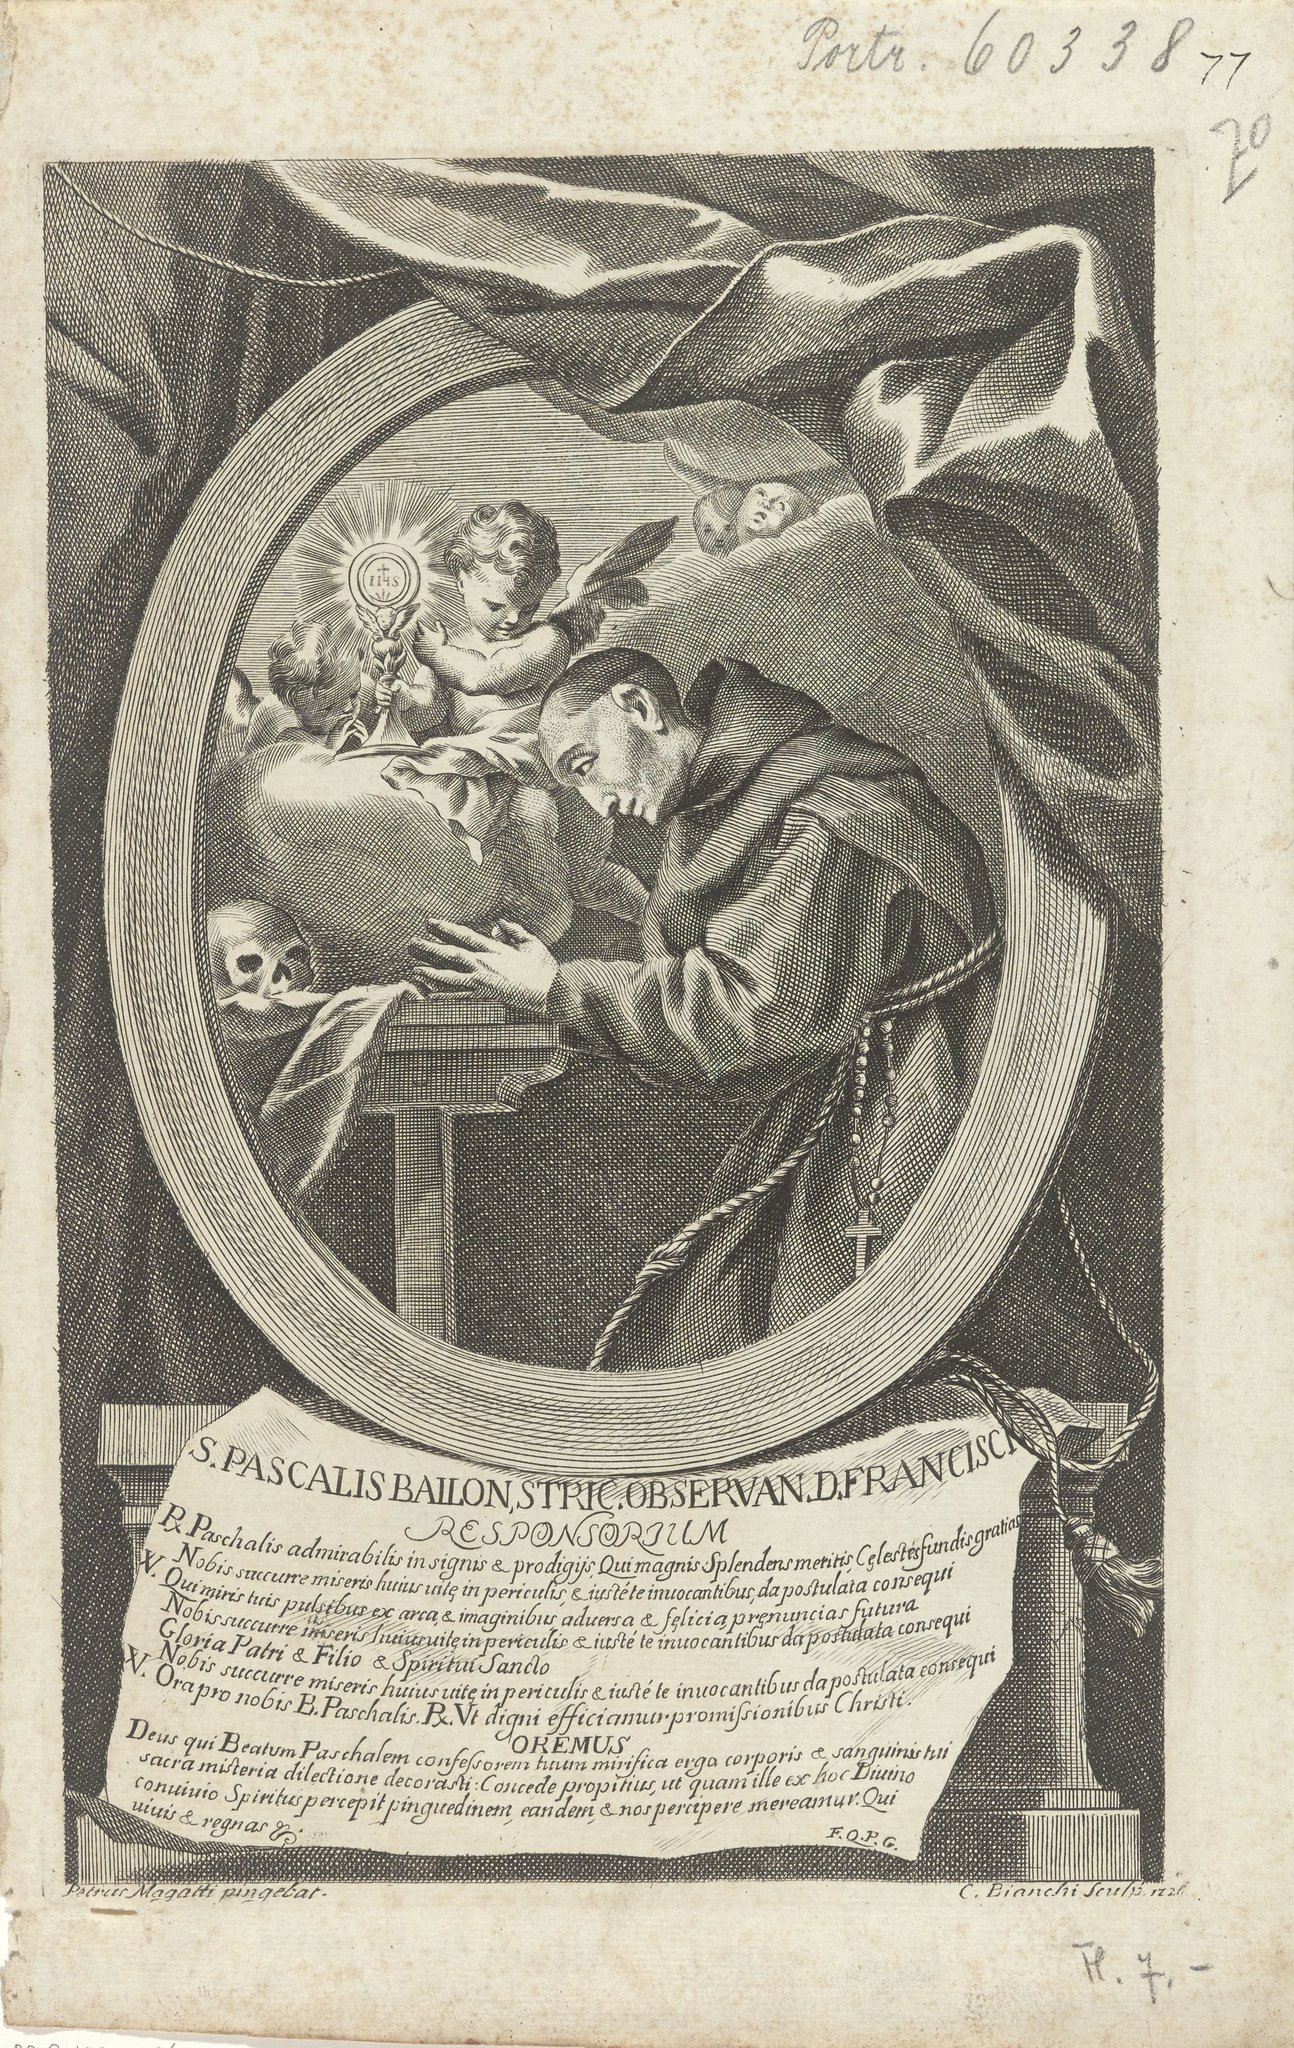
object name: print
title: De heilige Paschalis Baylon in aanbidding voor de hostie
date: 1600-1699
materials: paper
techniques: engraving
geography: italy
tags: male saints (paschalis baylon), adoration of the host, e.g. perpetual adoration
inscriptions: collector's mark: Lugt 2760, collector's mark: Lugt 2228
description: De heilige Paschalis Baylon zit, in een habijt van Franciscaner orde, geknield voor een tafel met daarop een schedel. Een putto houdt een monstrans met een hostie vast. De voorstelling is gevat in een ovale lijst, half verscholen achter een draperie. Onderschrift in Latijn.